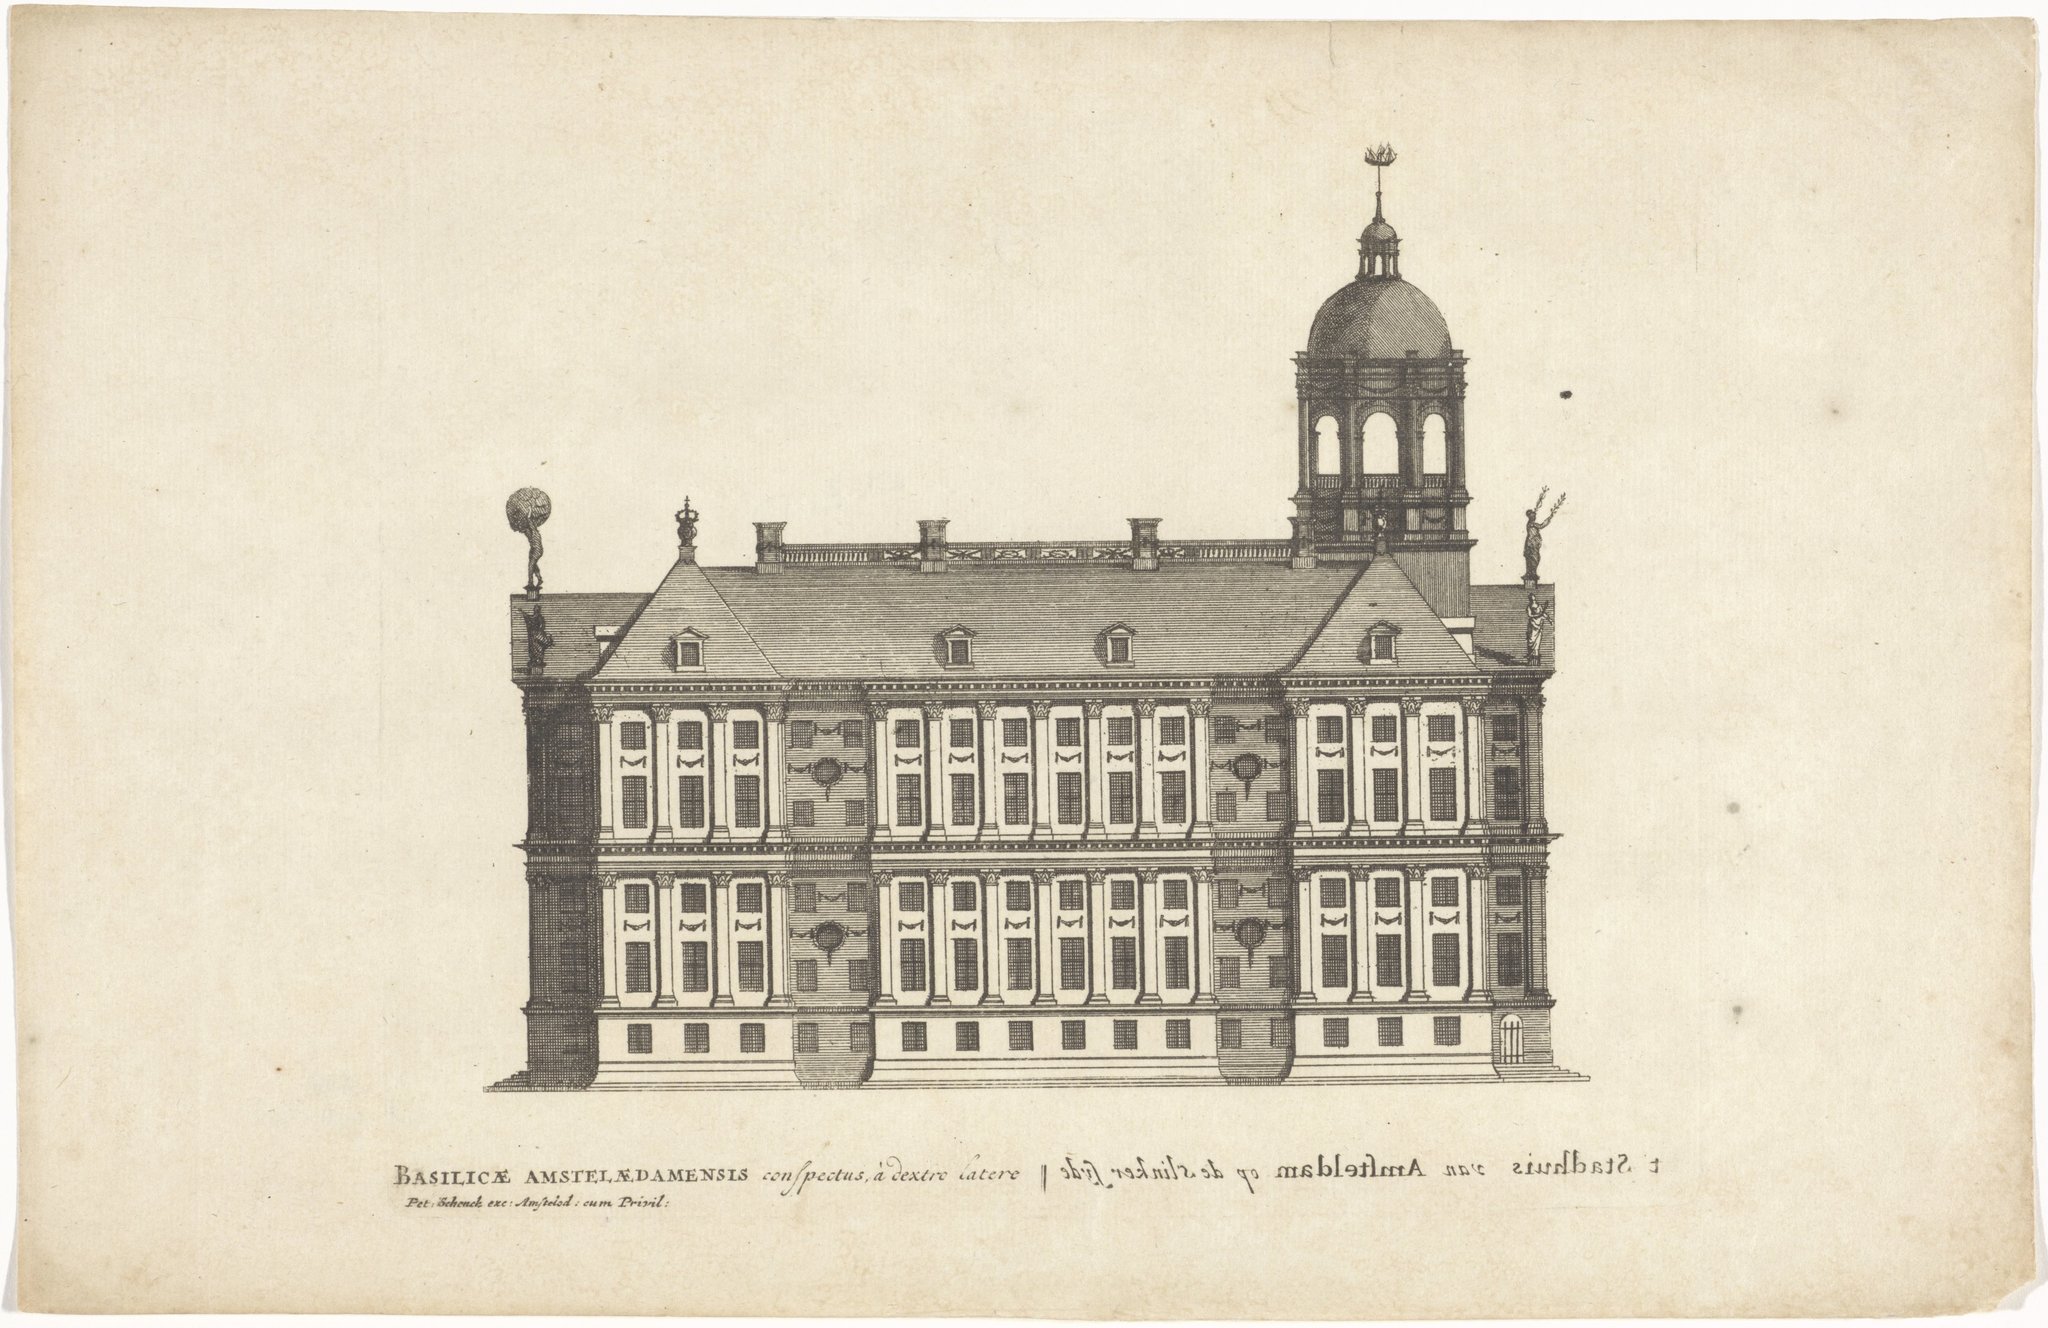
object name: print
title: Gezicht op de zijgevel van het Stadhuis op de Dam van Amsterdam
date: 1675-1711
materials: paper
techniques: etching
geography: amsterdam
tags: townhall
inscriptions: collector's mark: Lugt 2233